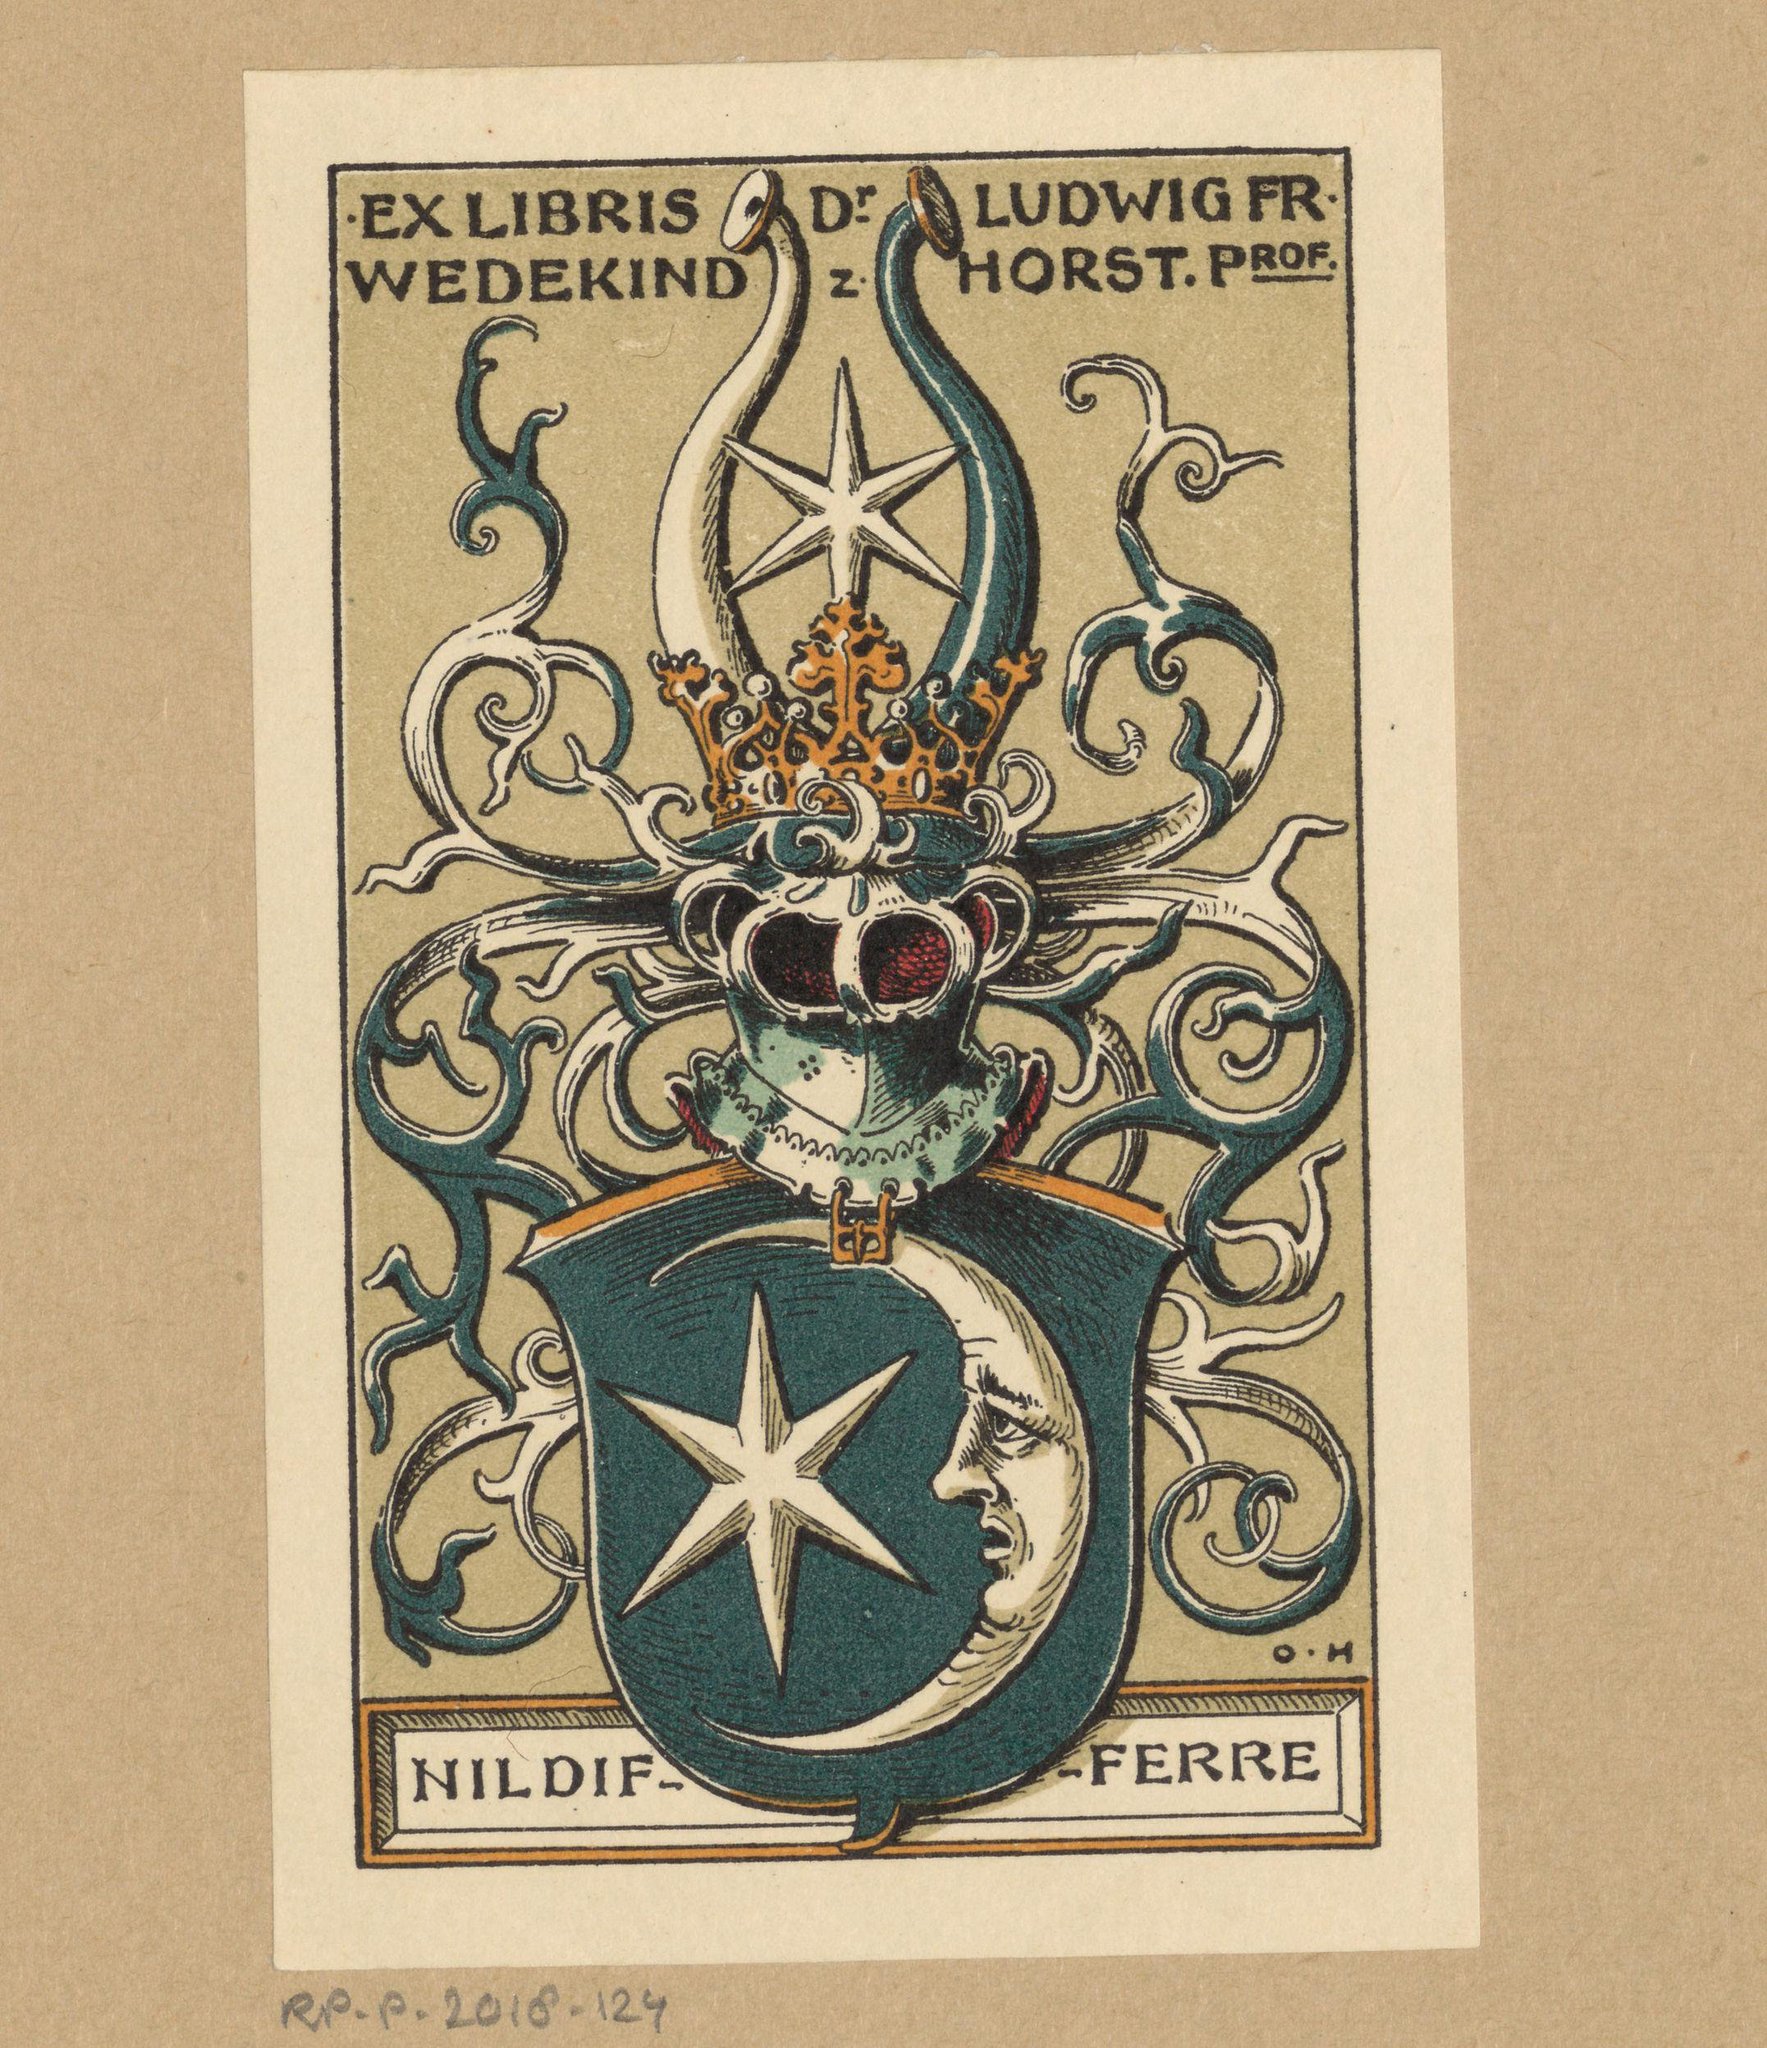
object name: bookplate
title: Ex libris van Ludwig baron von Wedekind zur Horst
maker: otto hupp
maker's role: print maker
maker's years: 1859-1949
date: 1869-1949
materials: paper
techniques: lithograph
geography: germany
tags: waxing moon represented as face, stars, armorial bearing, heraldry